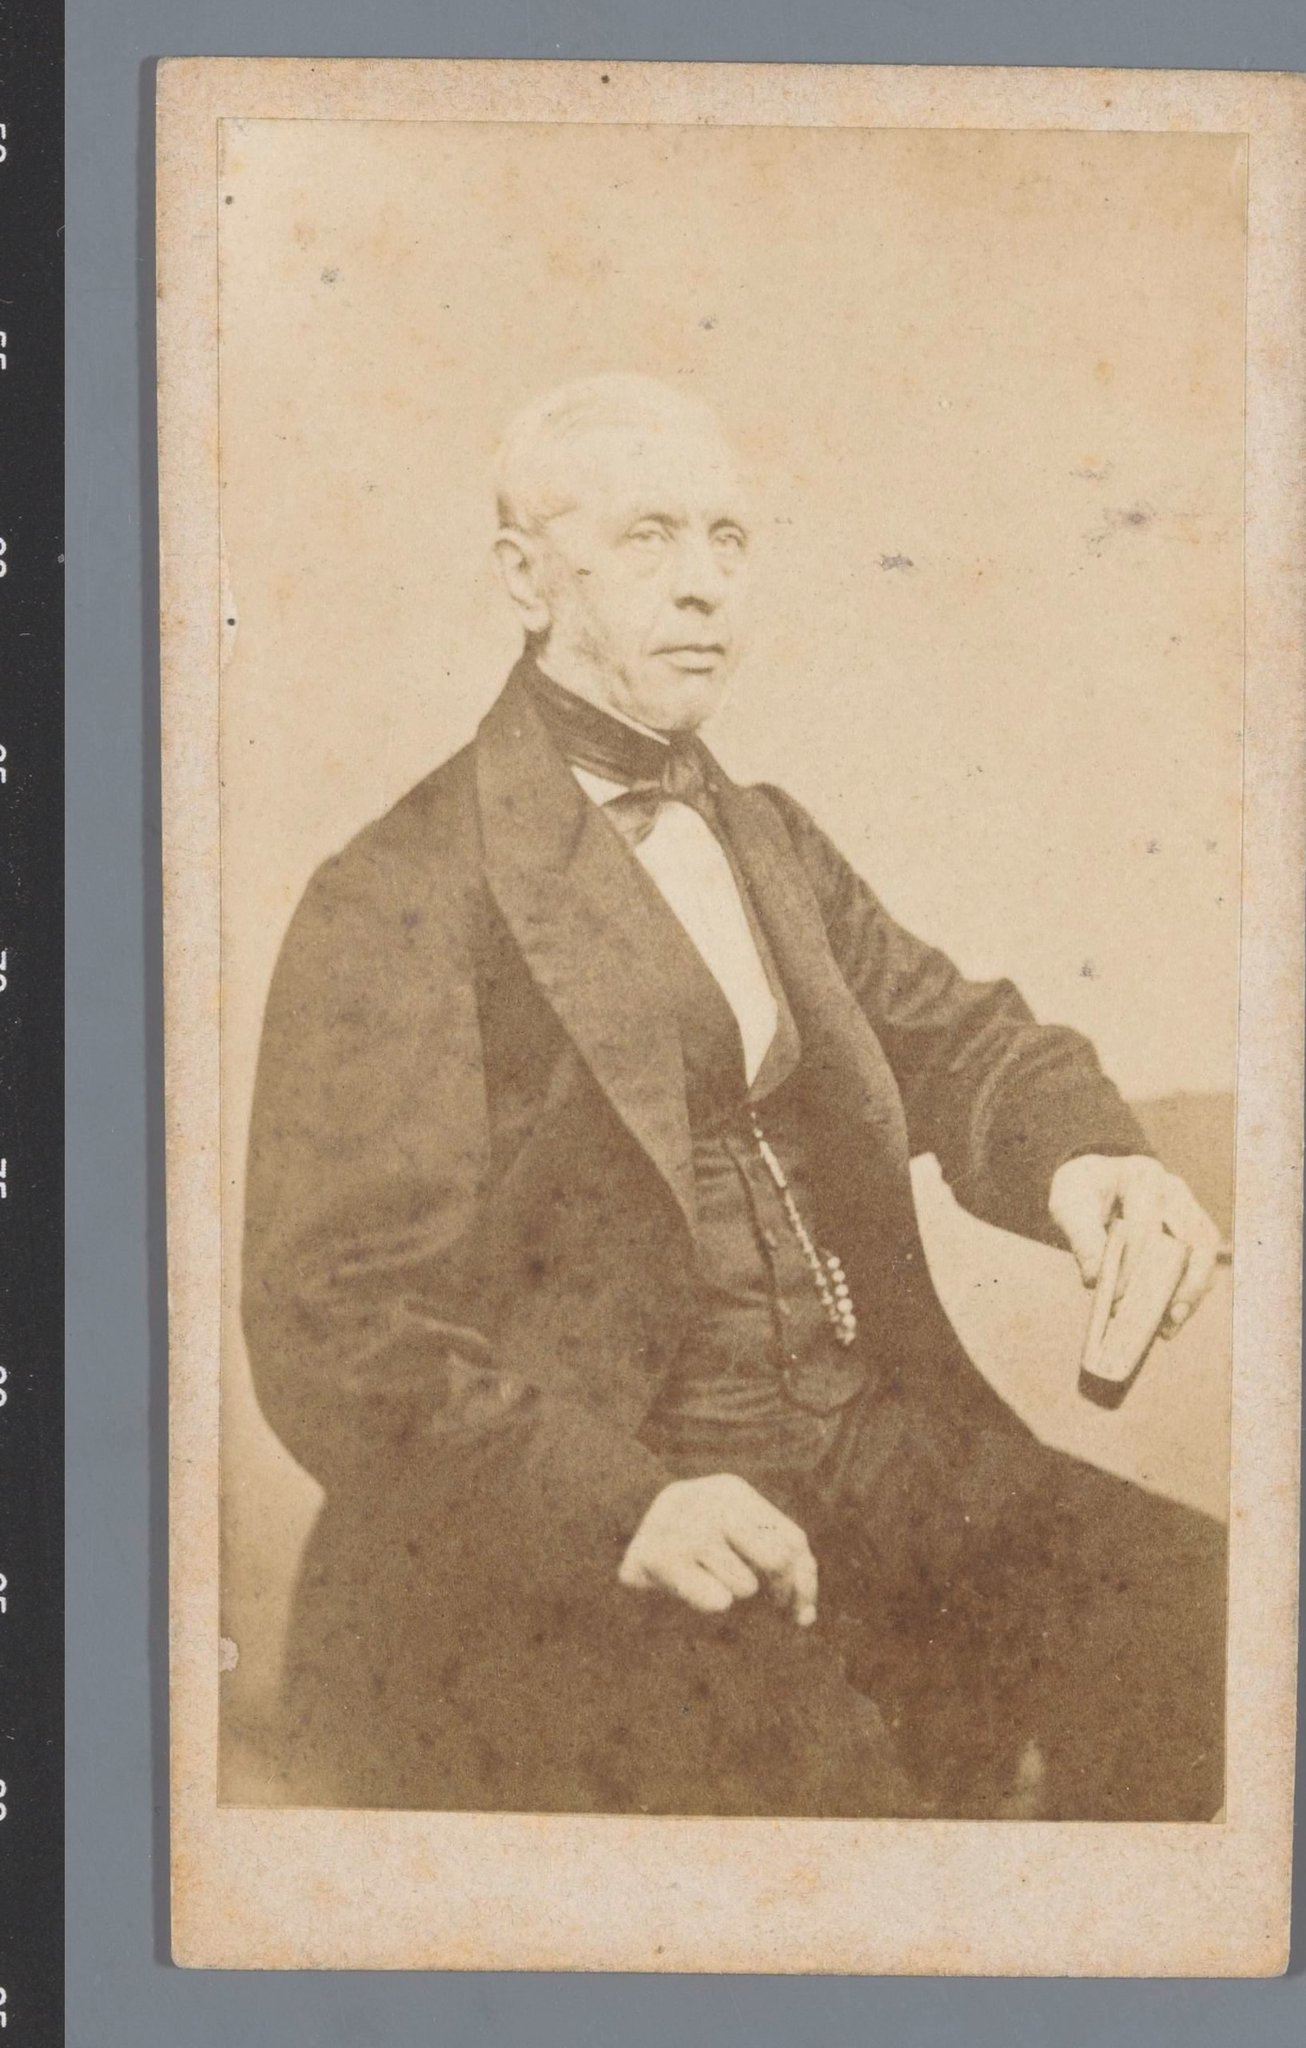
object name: carte de visite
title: Portret van de onderwijzer Pieter Daniel Anslijn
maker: Anonymous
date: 1850-1865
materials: cardboard, photographic support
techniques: albumen print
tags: historical persons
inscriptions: annotation: ‘Onderwijzer/ P. D. Anslijn’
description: Carte-de-visite is onderdeel van een groep portretten aangeboden aan A.J. Nijland, verzamelaar van historieprenten, in augustus 1878.